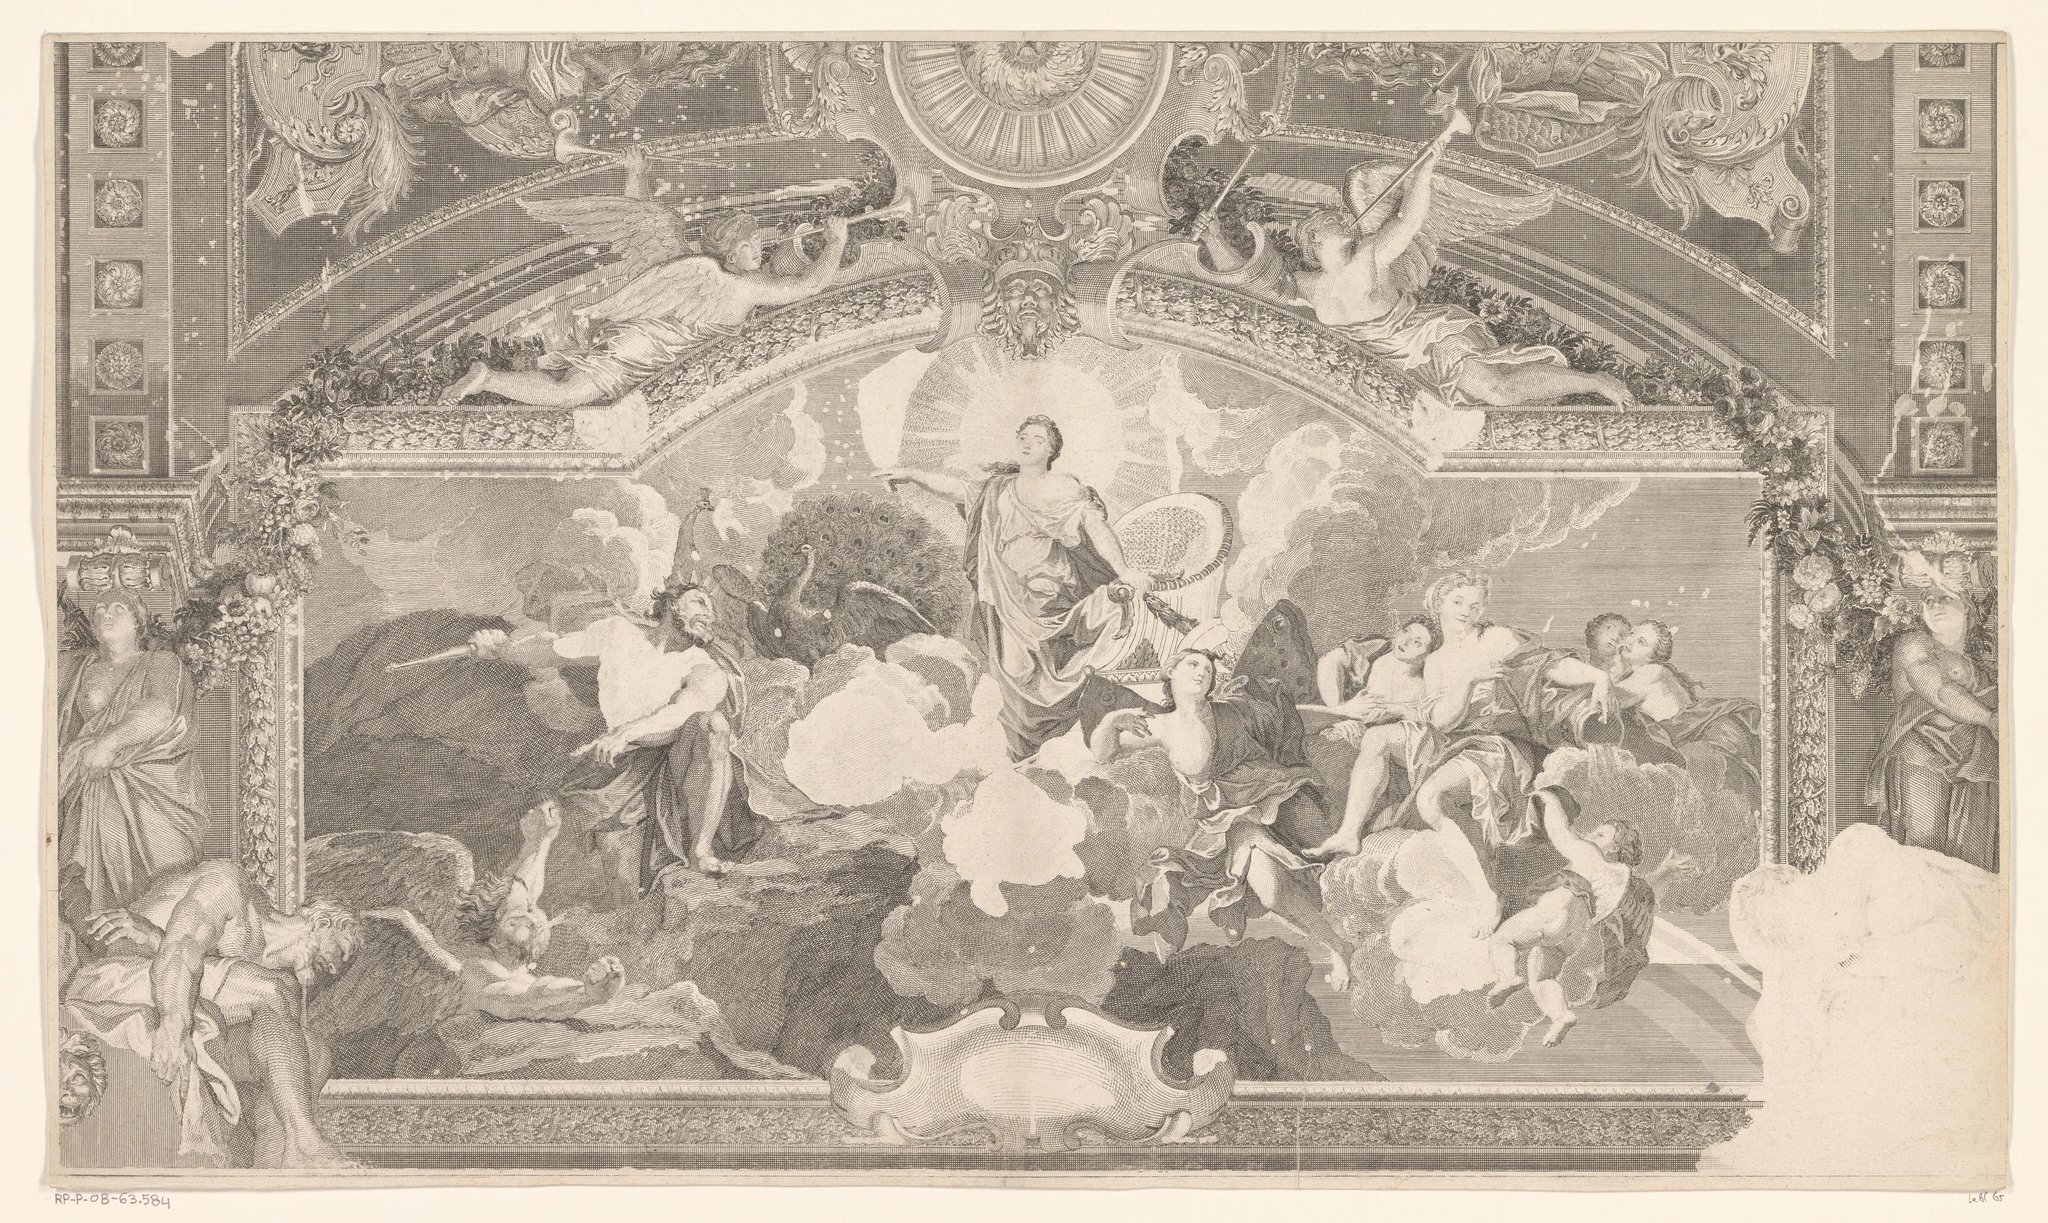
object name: print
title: Scènes uit de Aeneis in het Palais Royal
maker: nicolas henri tardieu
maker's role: print maker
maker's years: 1674-1749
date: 1719-1749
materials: paper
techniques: engraving, etching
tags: (story of) aeolus, guardian of the winds; 'eolo' (ripa), juno asks aeolus to set the winds free (virgil, aeneid i 50-86)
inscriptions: collector's mark: Lugt 240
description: Serie prenten naar schilderijen van Coypel met als thema de Aeneas van Virgilius, in de Galerie van het Palais Royal.